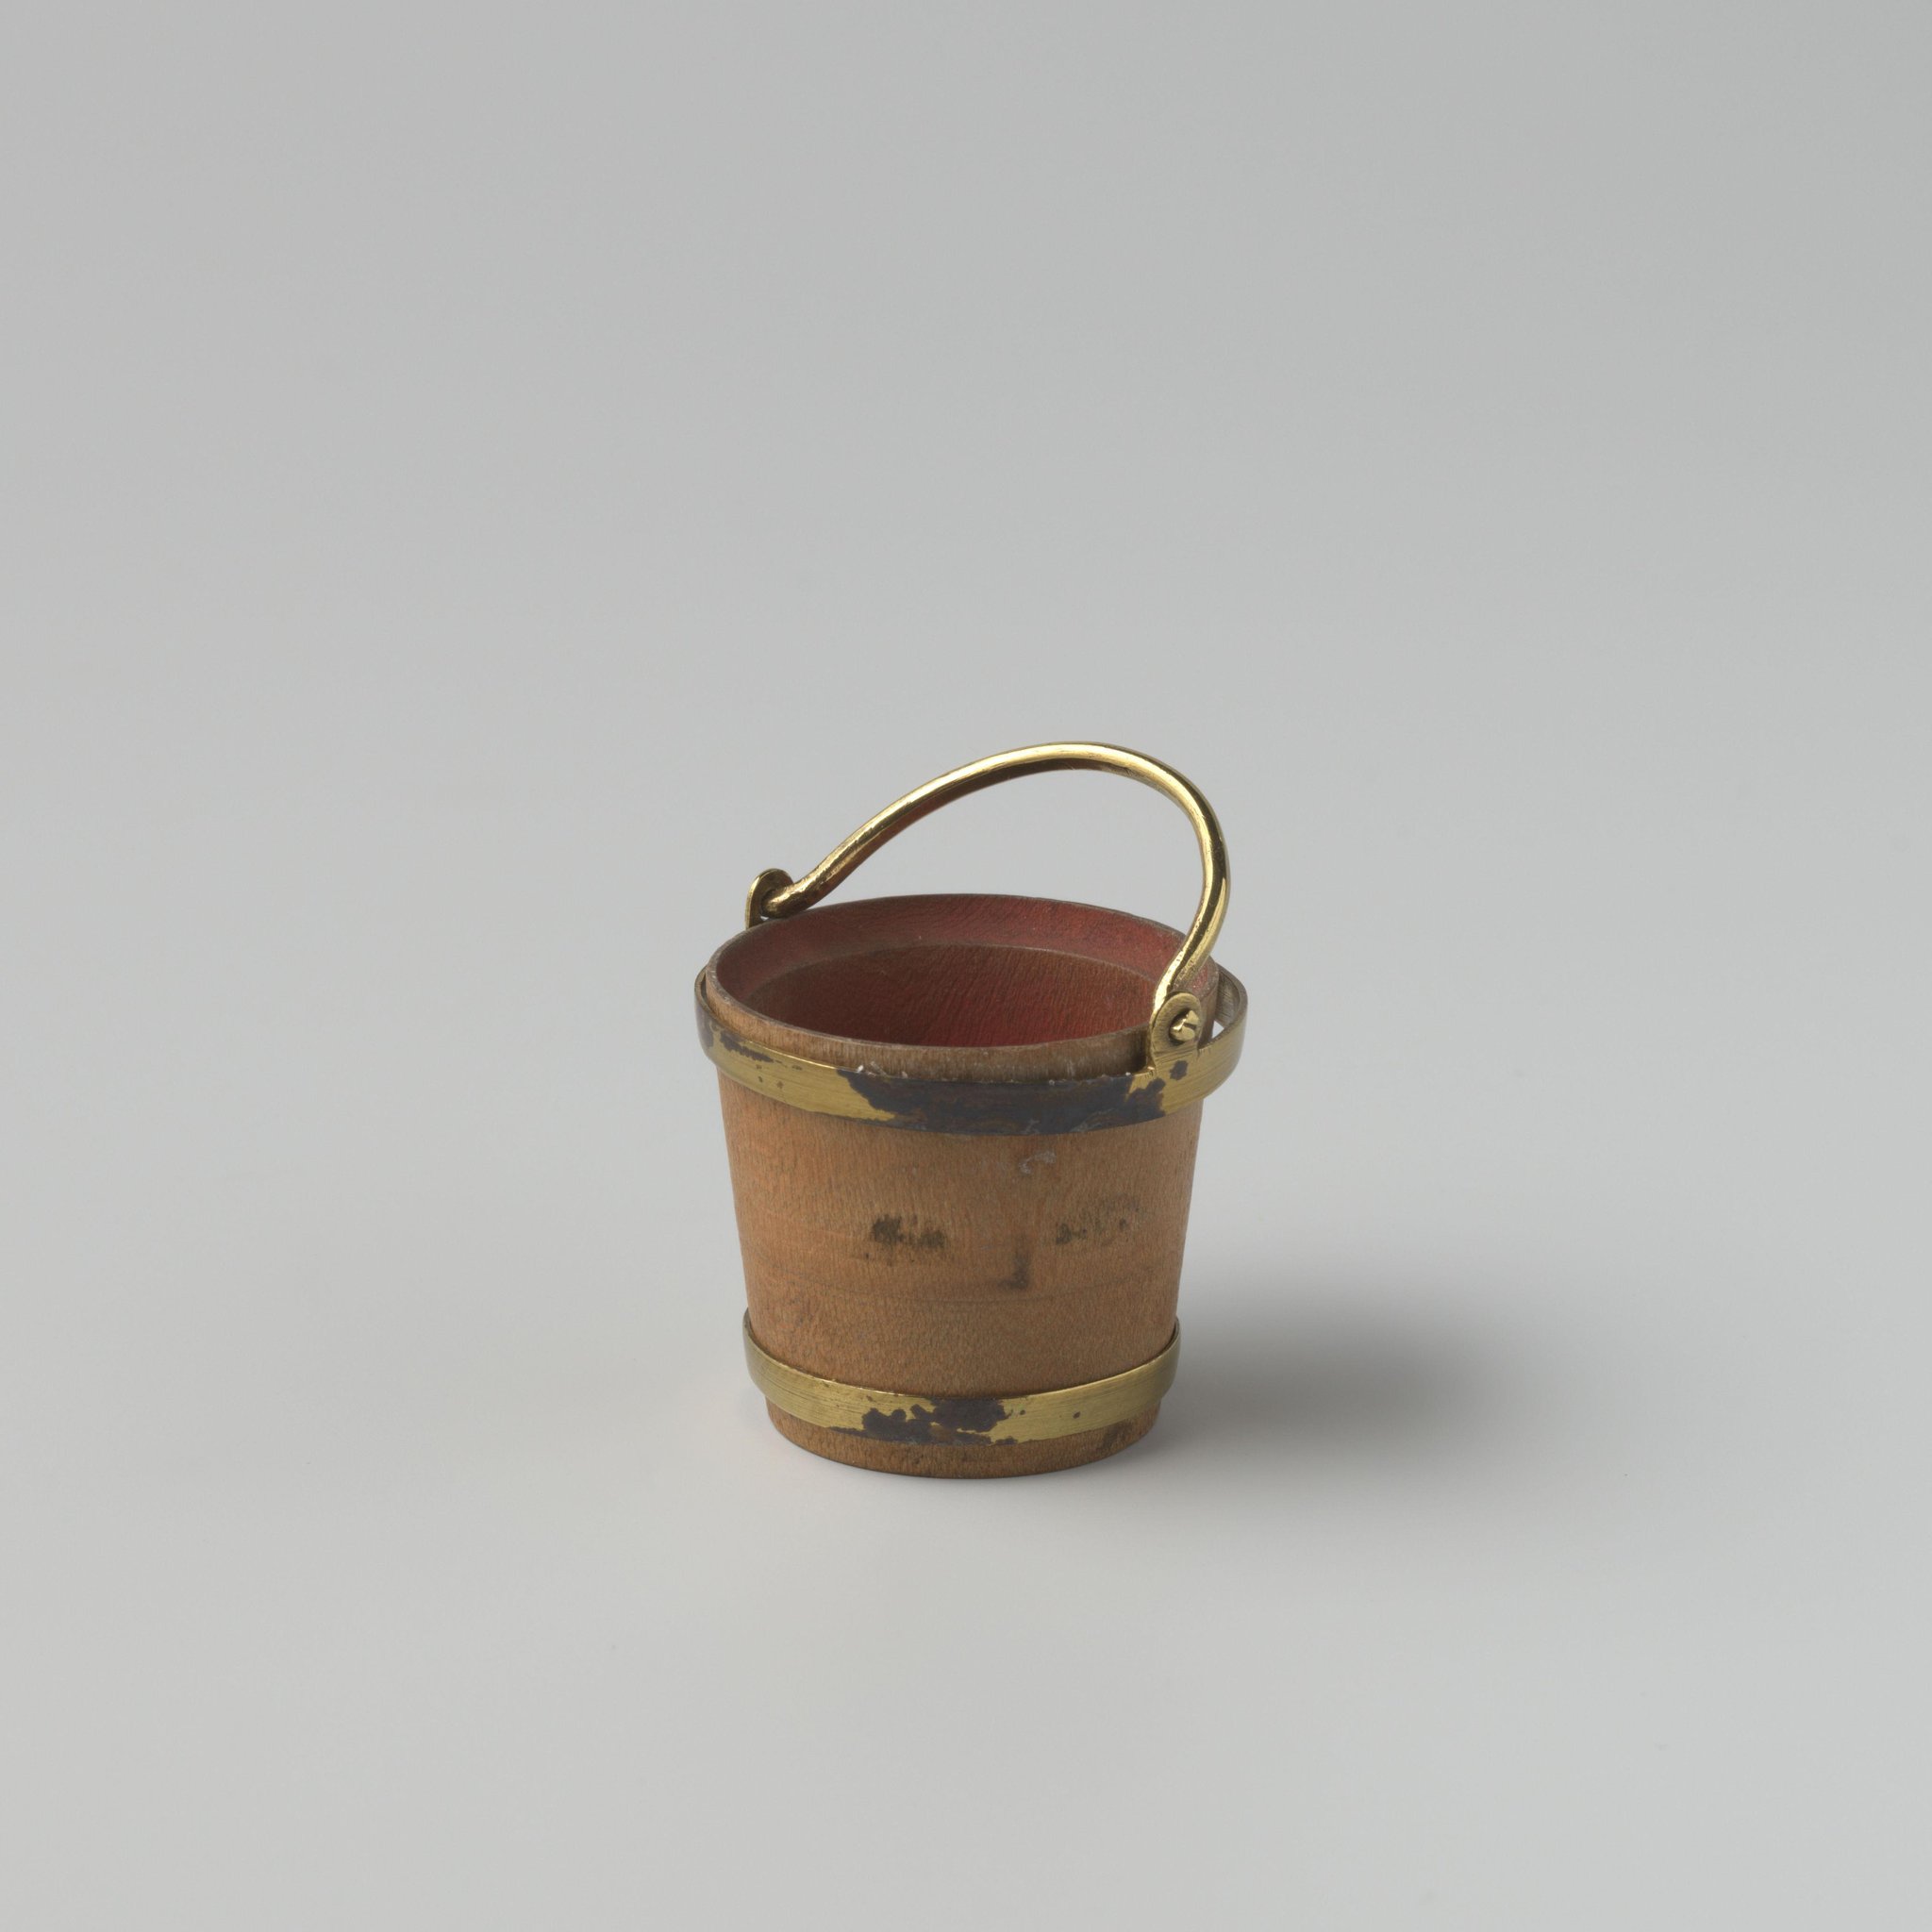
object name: miniature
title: Houten emmer met koperen hoepels aan boven- en onderrand, hengsel aan bovenste hoepel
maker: Anonymous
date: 1690-1710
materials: copper, wood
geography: amsterdam